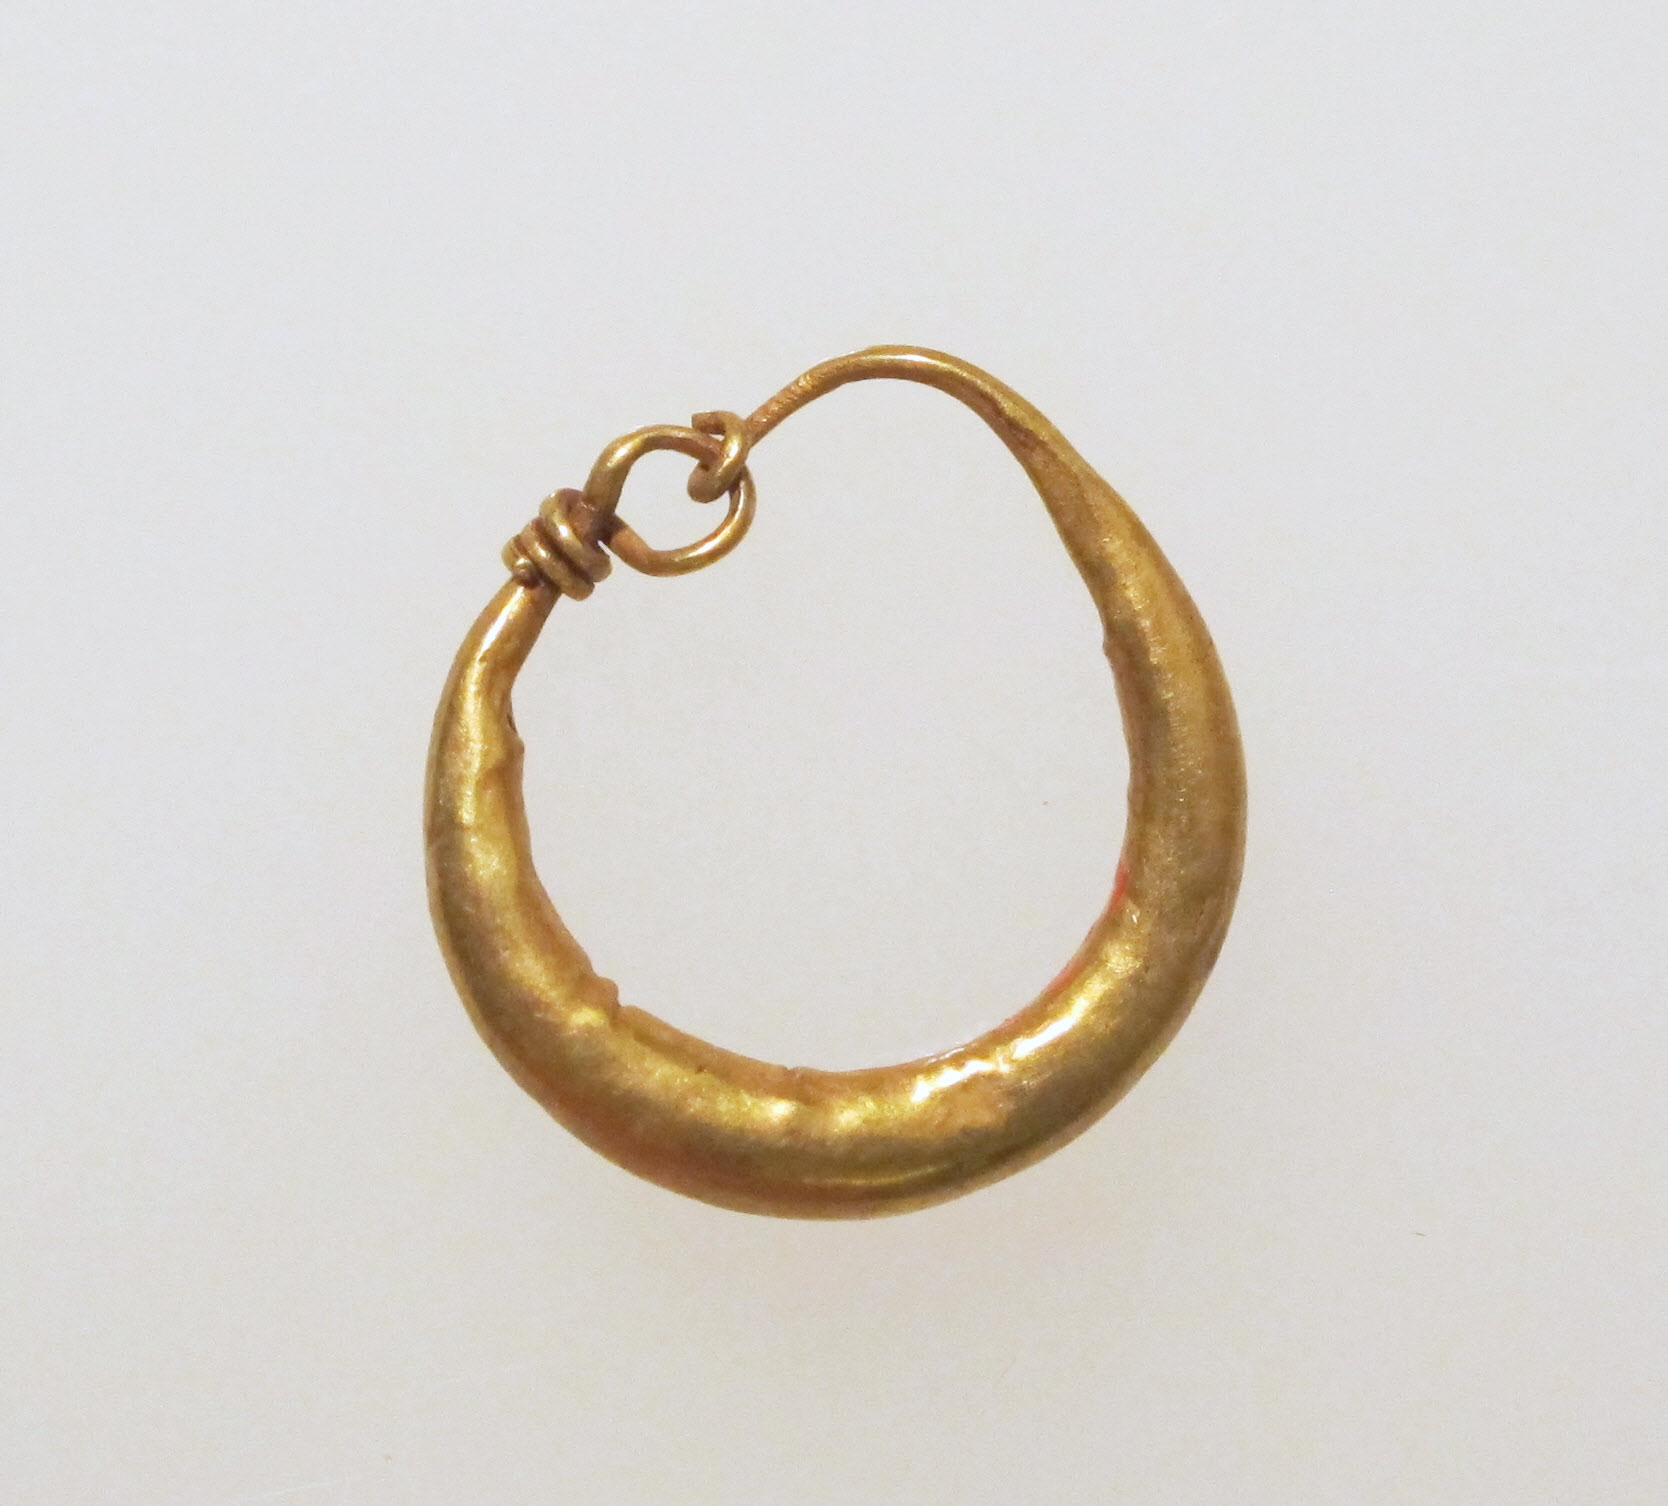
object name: earring loop type, plain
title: Earring-loop type, plain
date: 7000 BCE-330 CE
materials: gold